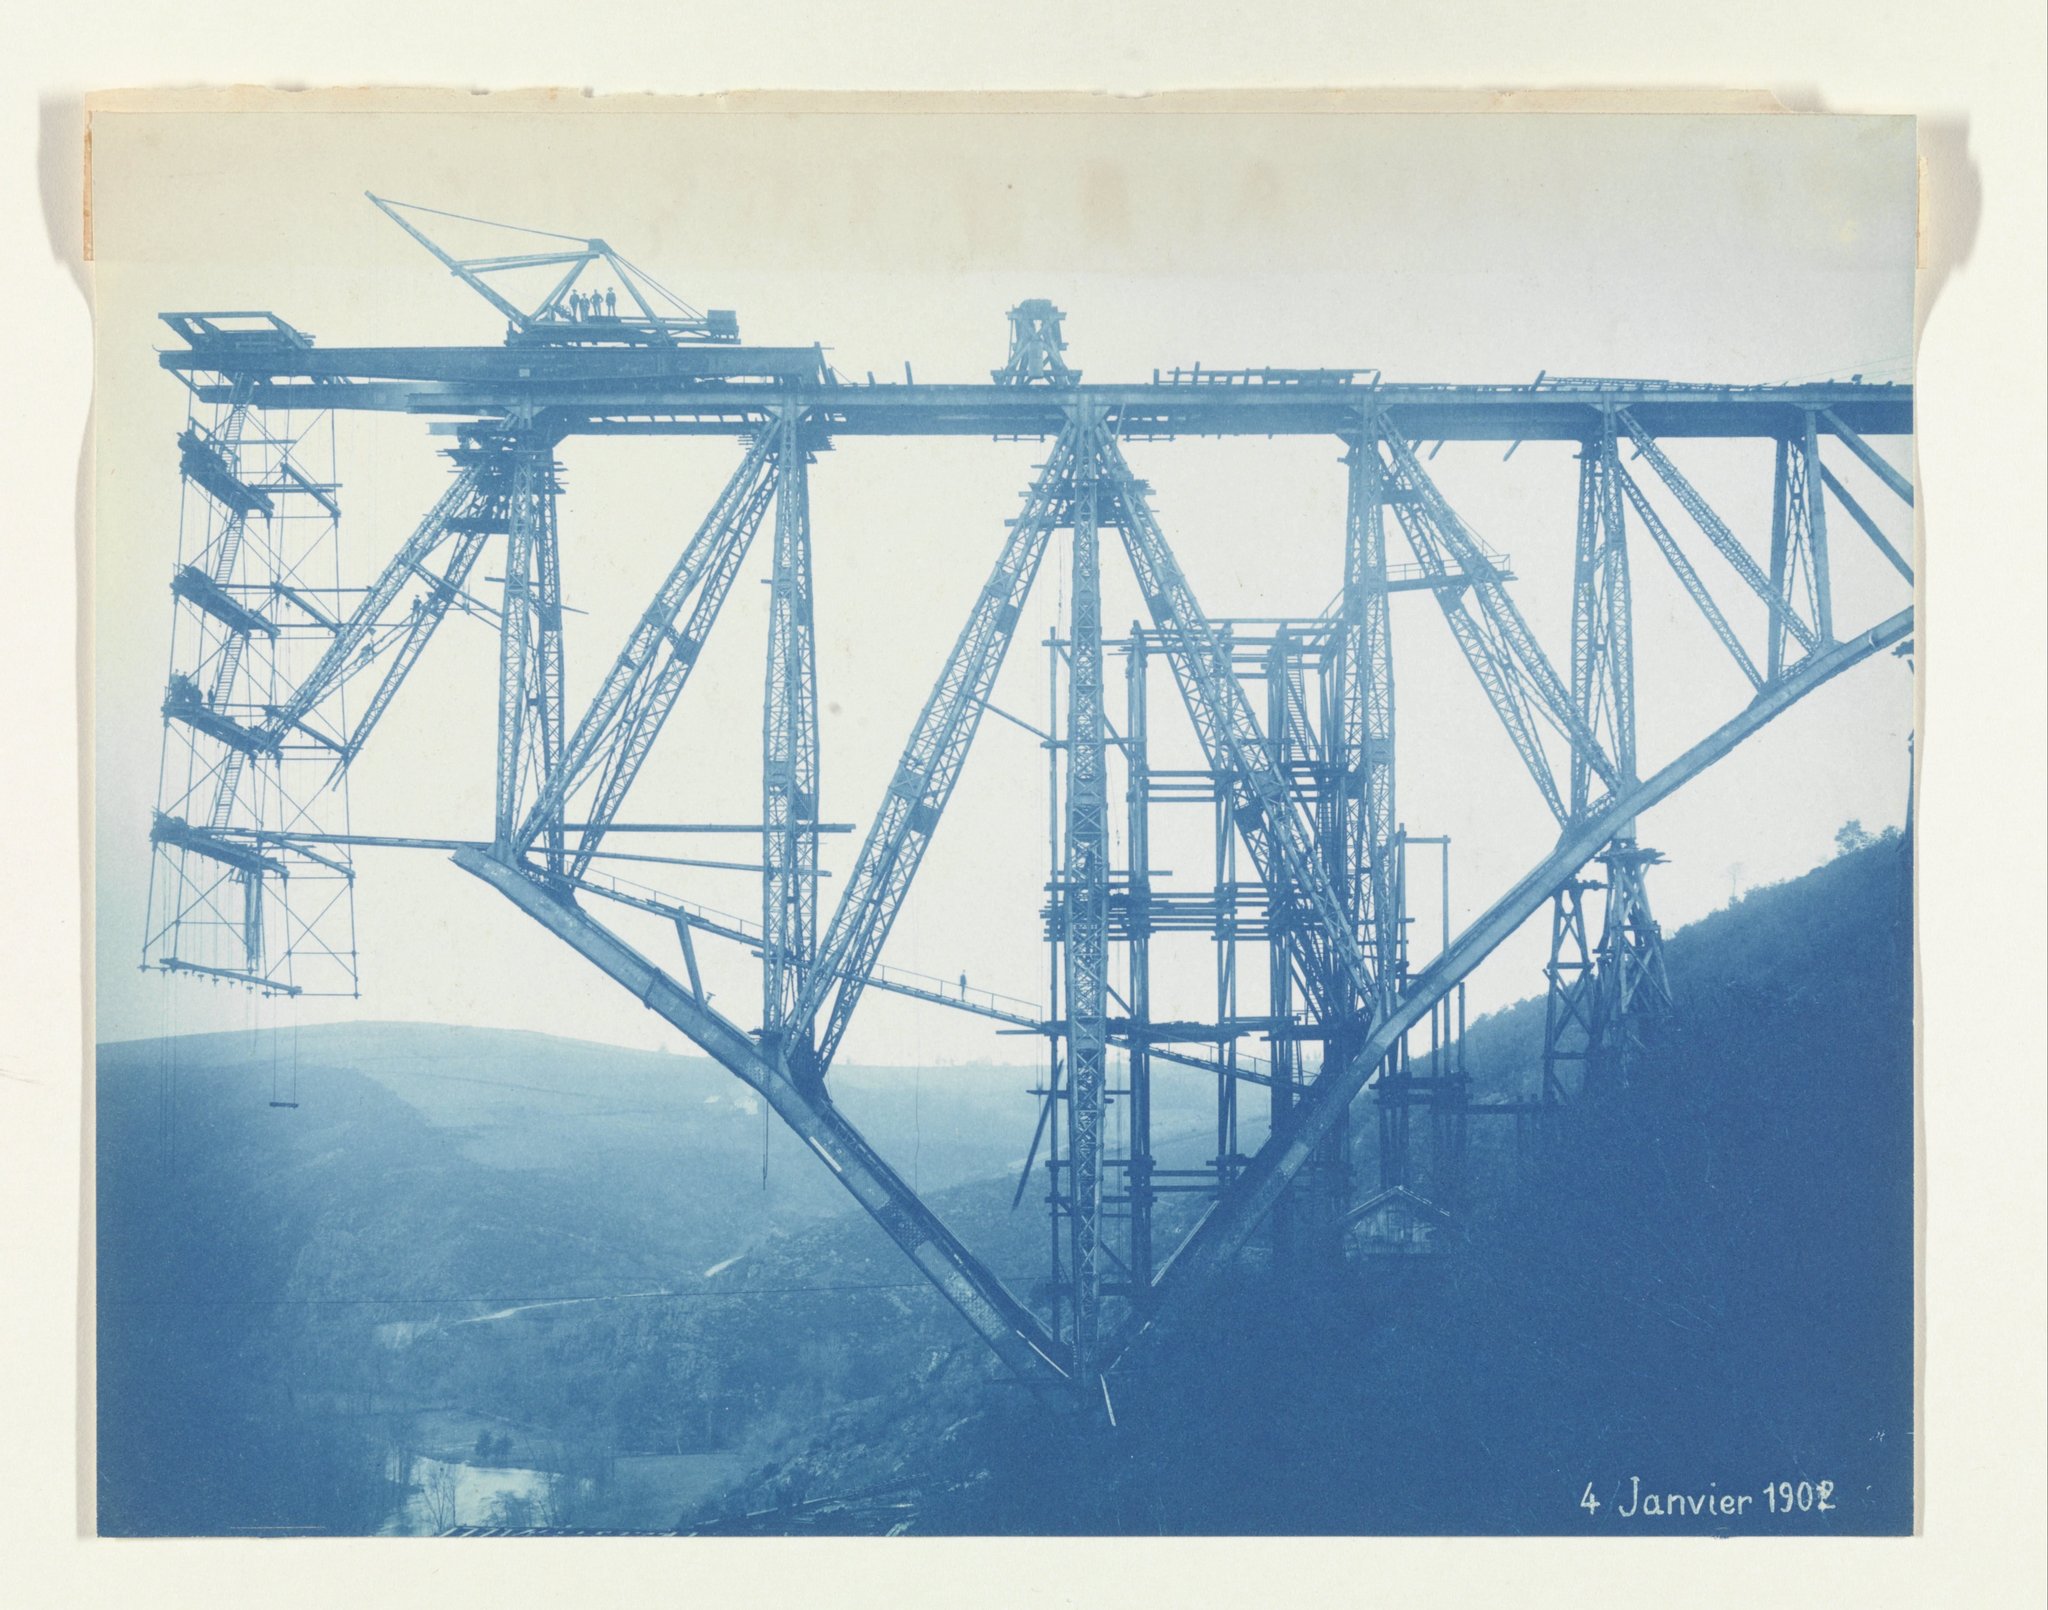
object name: photograph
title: Aanleg van het Viaur Viaduct in Frankrijk door de Societé de Construction des Battignolles, 4 januari 1902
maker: Anonymous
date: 1902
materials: photographic support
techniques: cyanotype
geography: france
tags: viaduct, making the overground structures (~ building activities)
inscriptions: date